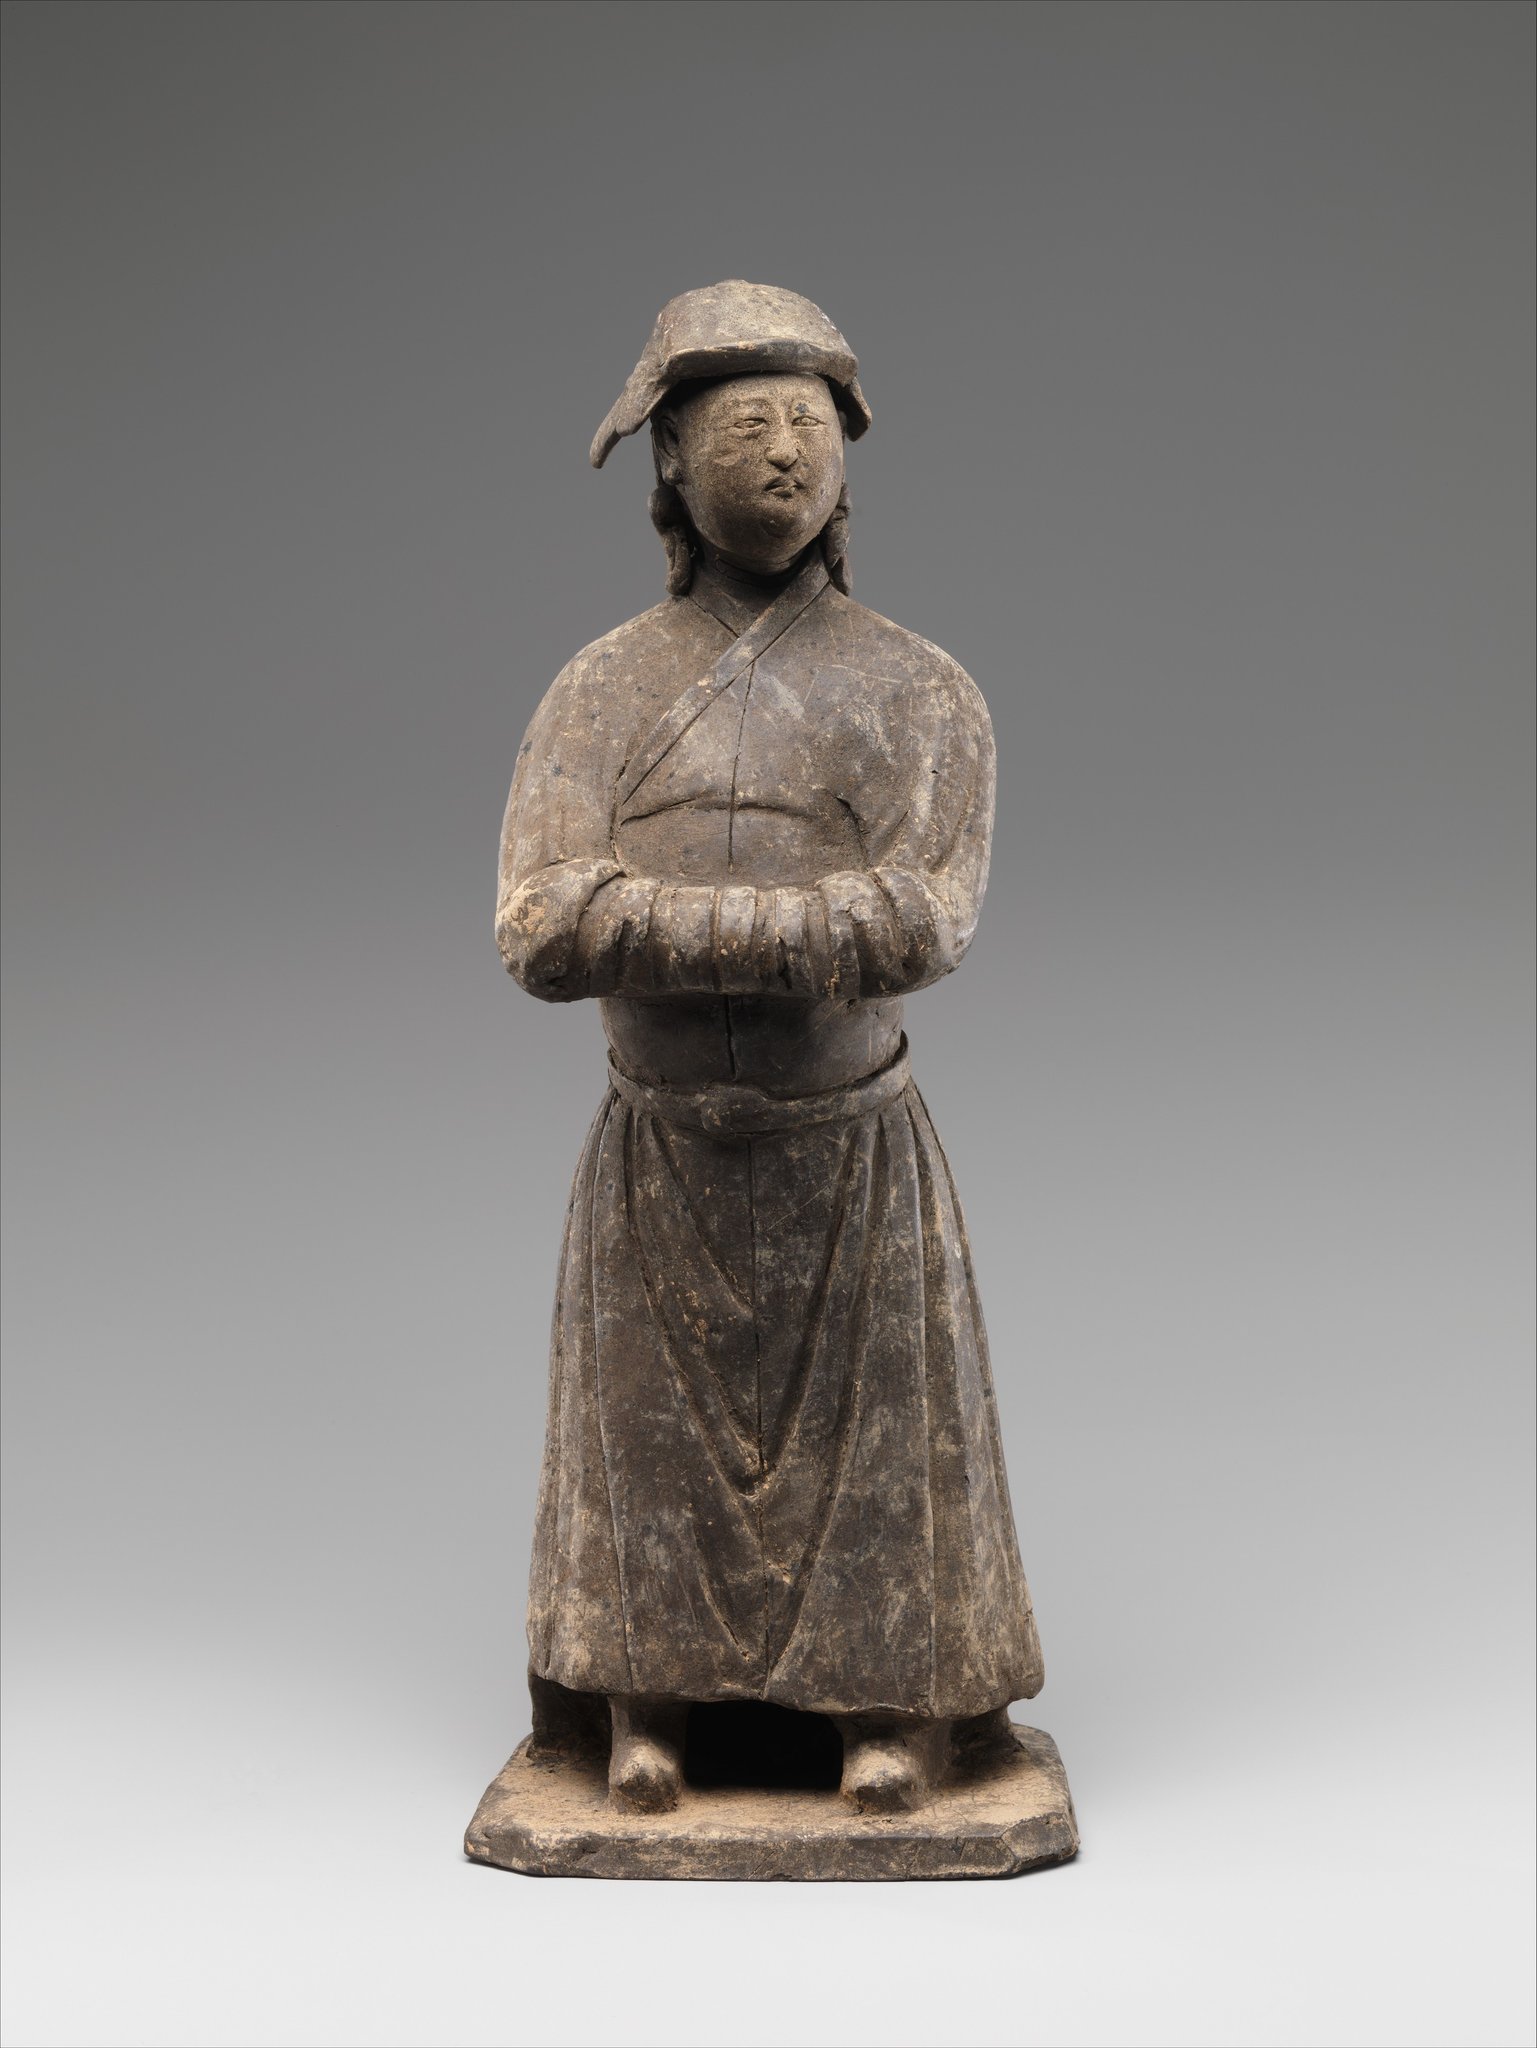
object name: figure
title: Figure of Mongol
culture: chinese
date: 1301-1400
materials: earthenware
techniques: burnishing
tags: men